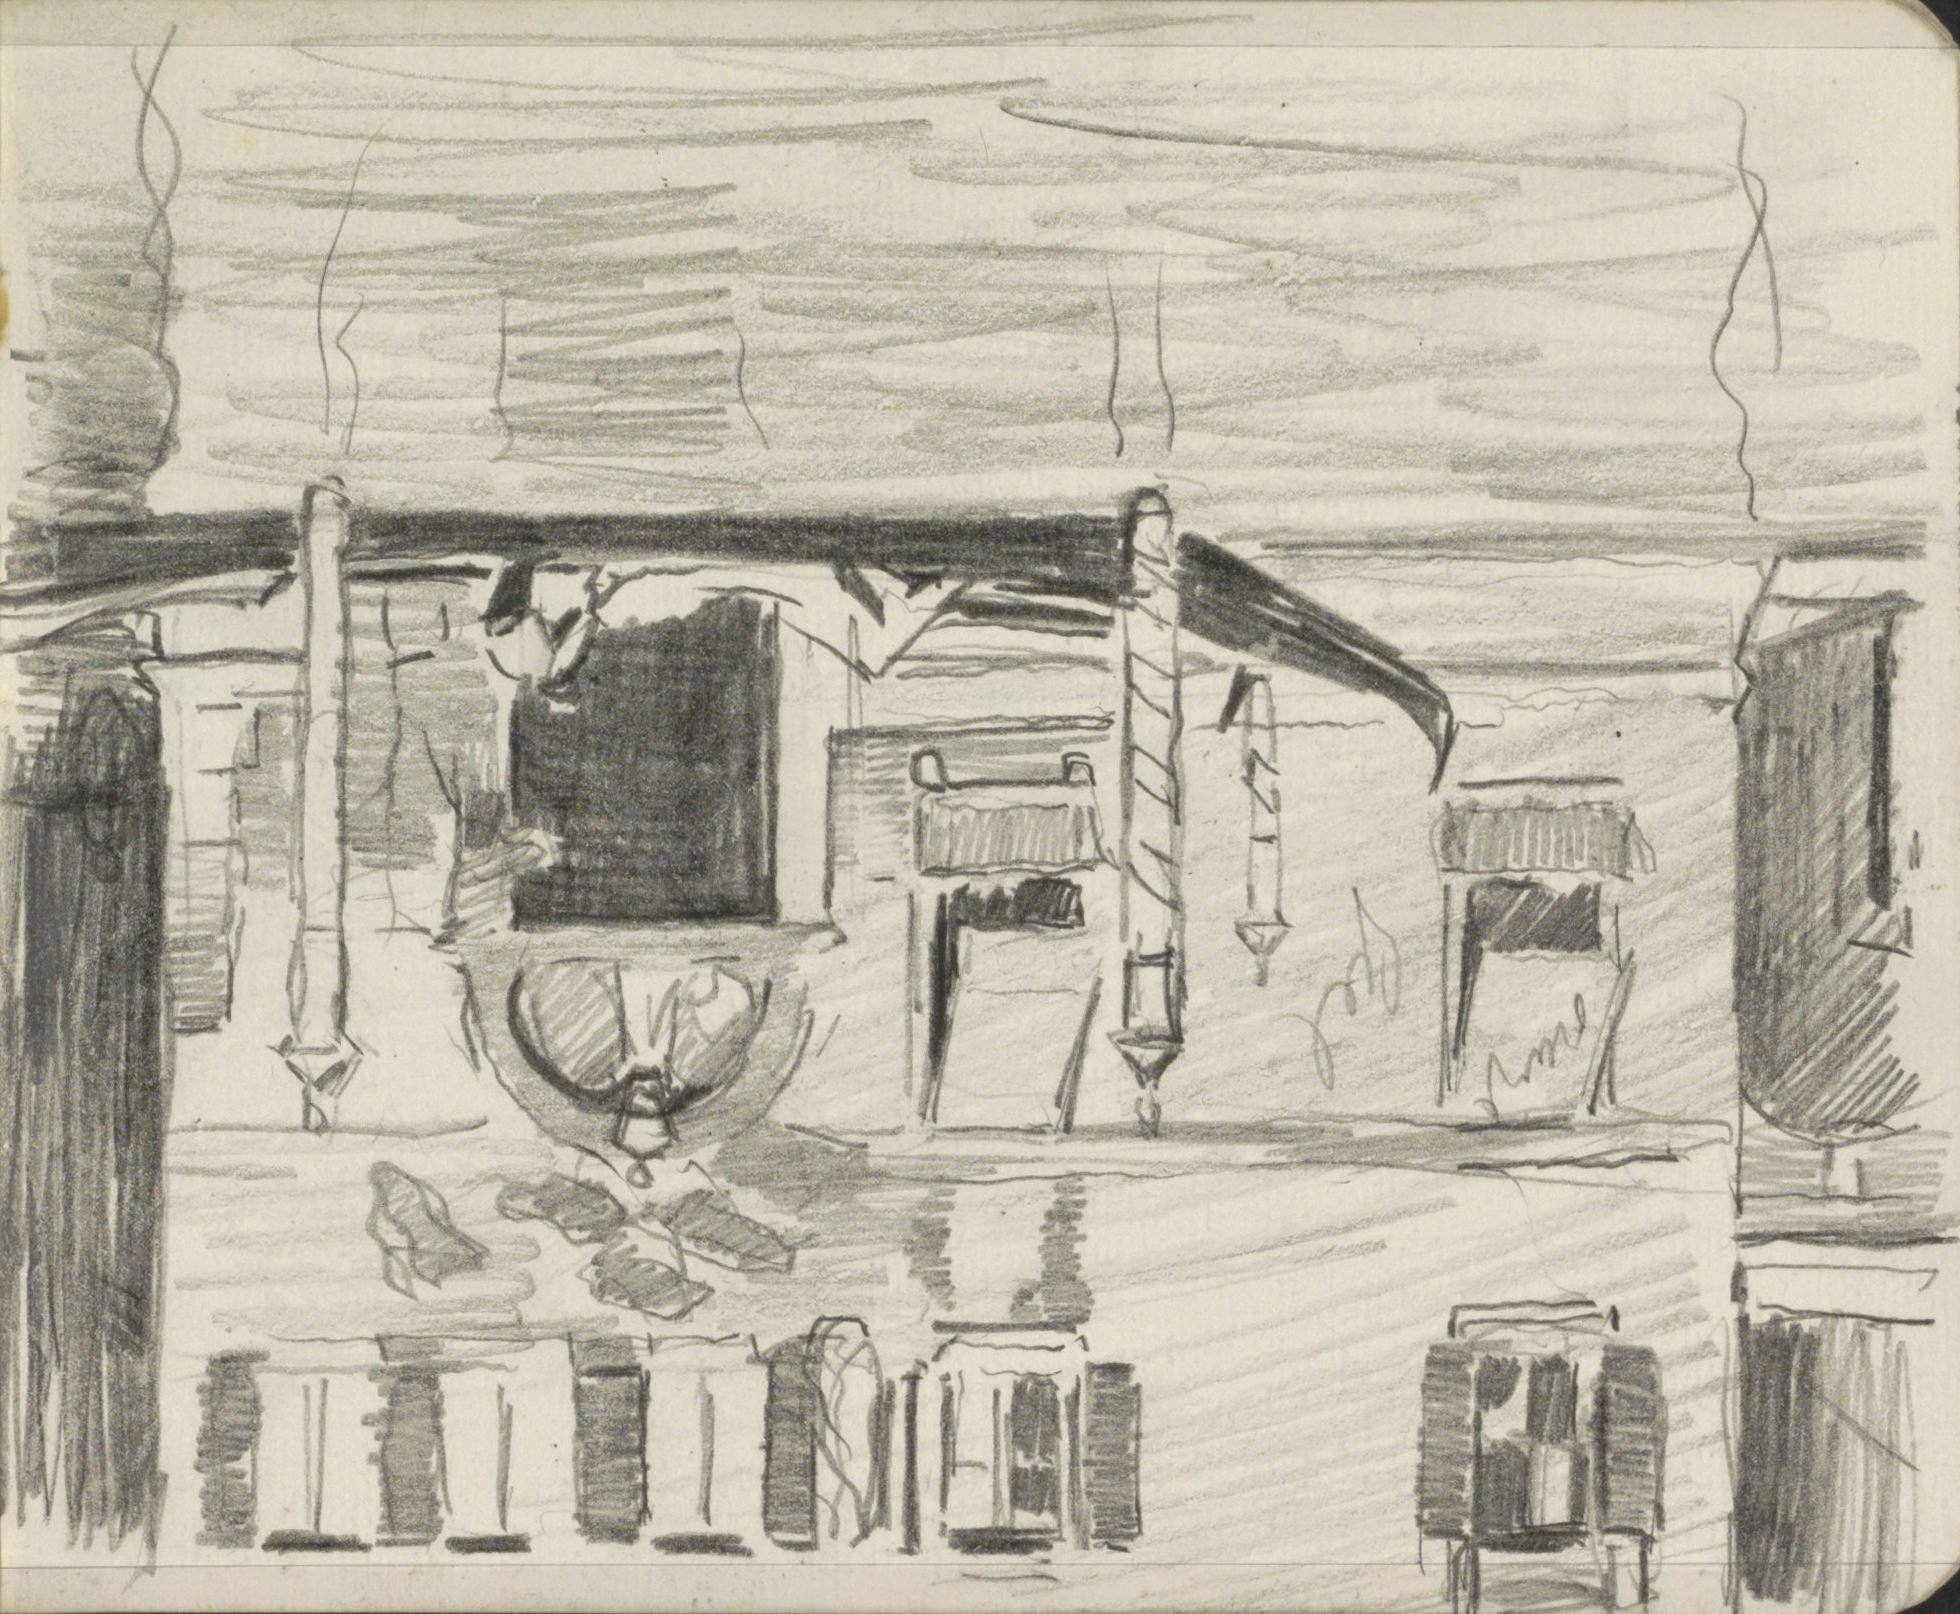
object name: sketchbook leaf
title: Gondola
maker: willem witsen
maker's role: draughtsman, painter, print maker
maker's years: 1860-1923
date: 1914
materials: paper, pencil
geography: venice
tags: canals, waters (in city), gondola, civic architecture; edifices; dwellings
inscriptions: watermark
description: Pagina 29 uit een schetsboek met 26 bladen. Toont een huis aan het Canal Grande dat is ingeklemd tussen Ramo Moro Lin en Ramo Grassi.